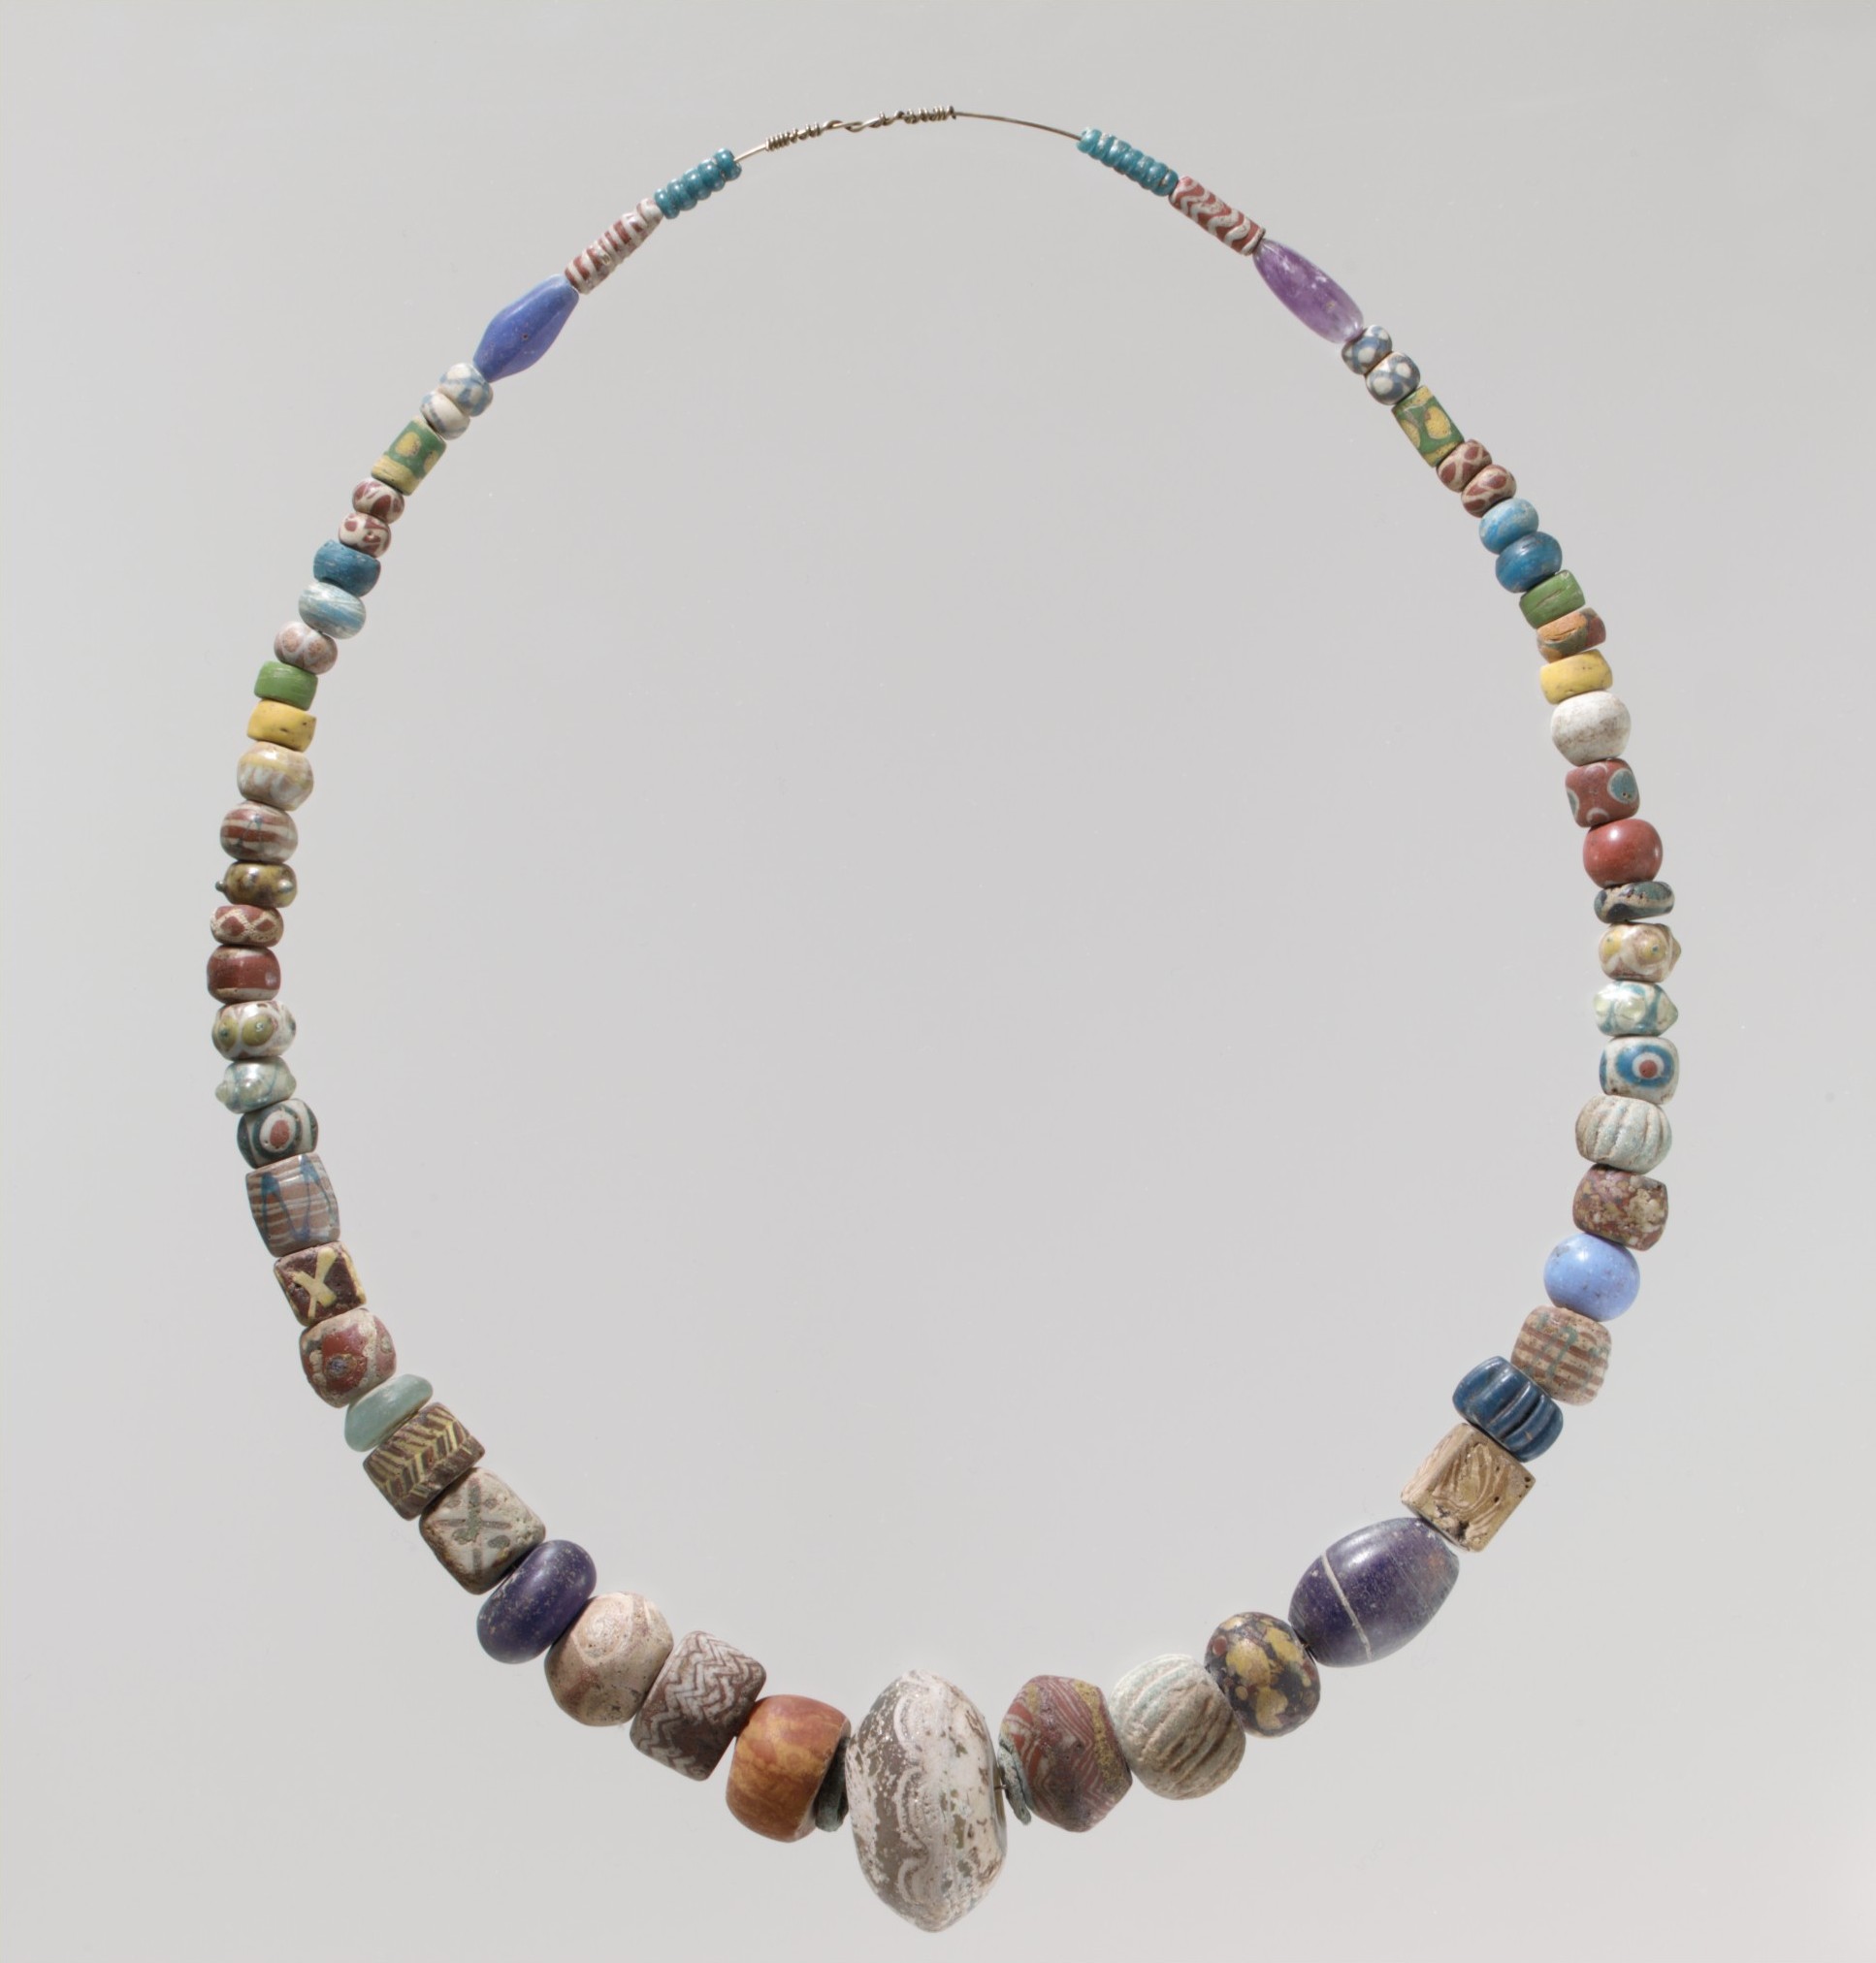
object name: necklace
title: Beads from a Necklace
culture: frankish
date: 500-600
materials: gemstone, copper alloy, glass